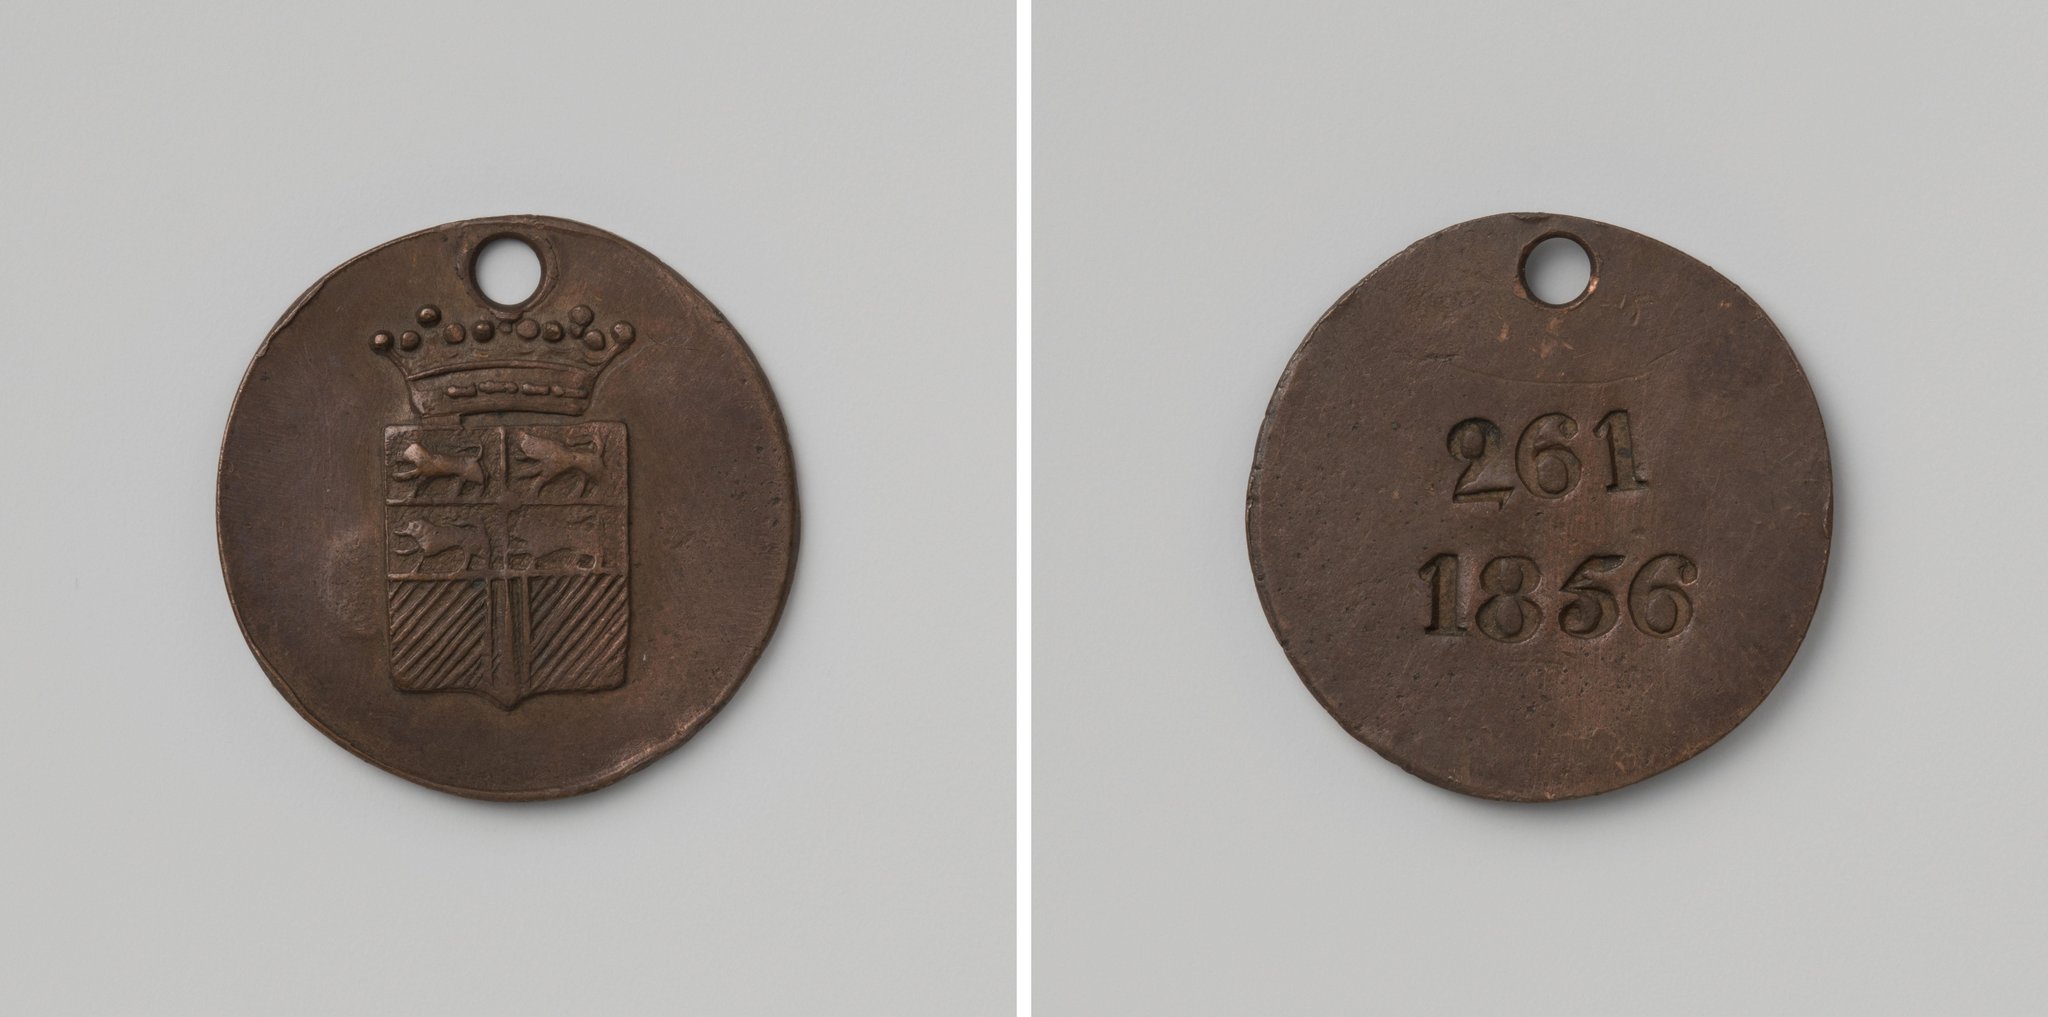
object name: tax token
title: Stad Rotterdam, loodje met no. 261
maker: Anonymous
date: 1856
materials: copper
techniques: striking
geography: rotterdam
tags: rotterdam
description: loodje met gat erin. Voorzijde: gekroond wapenschild. Keerzijde: cijfer no. 261 boven jaartal